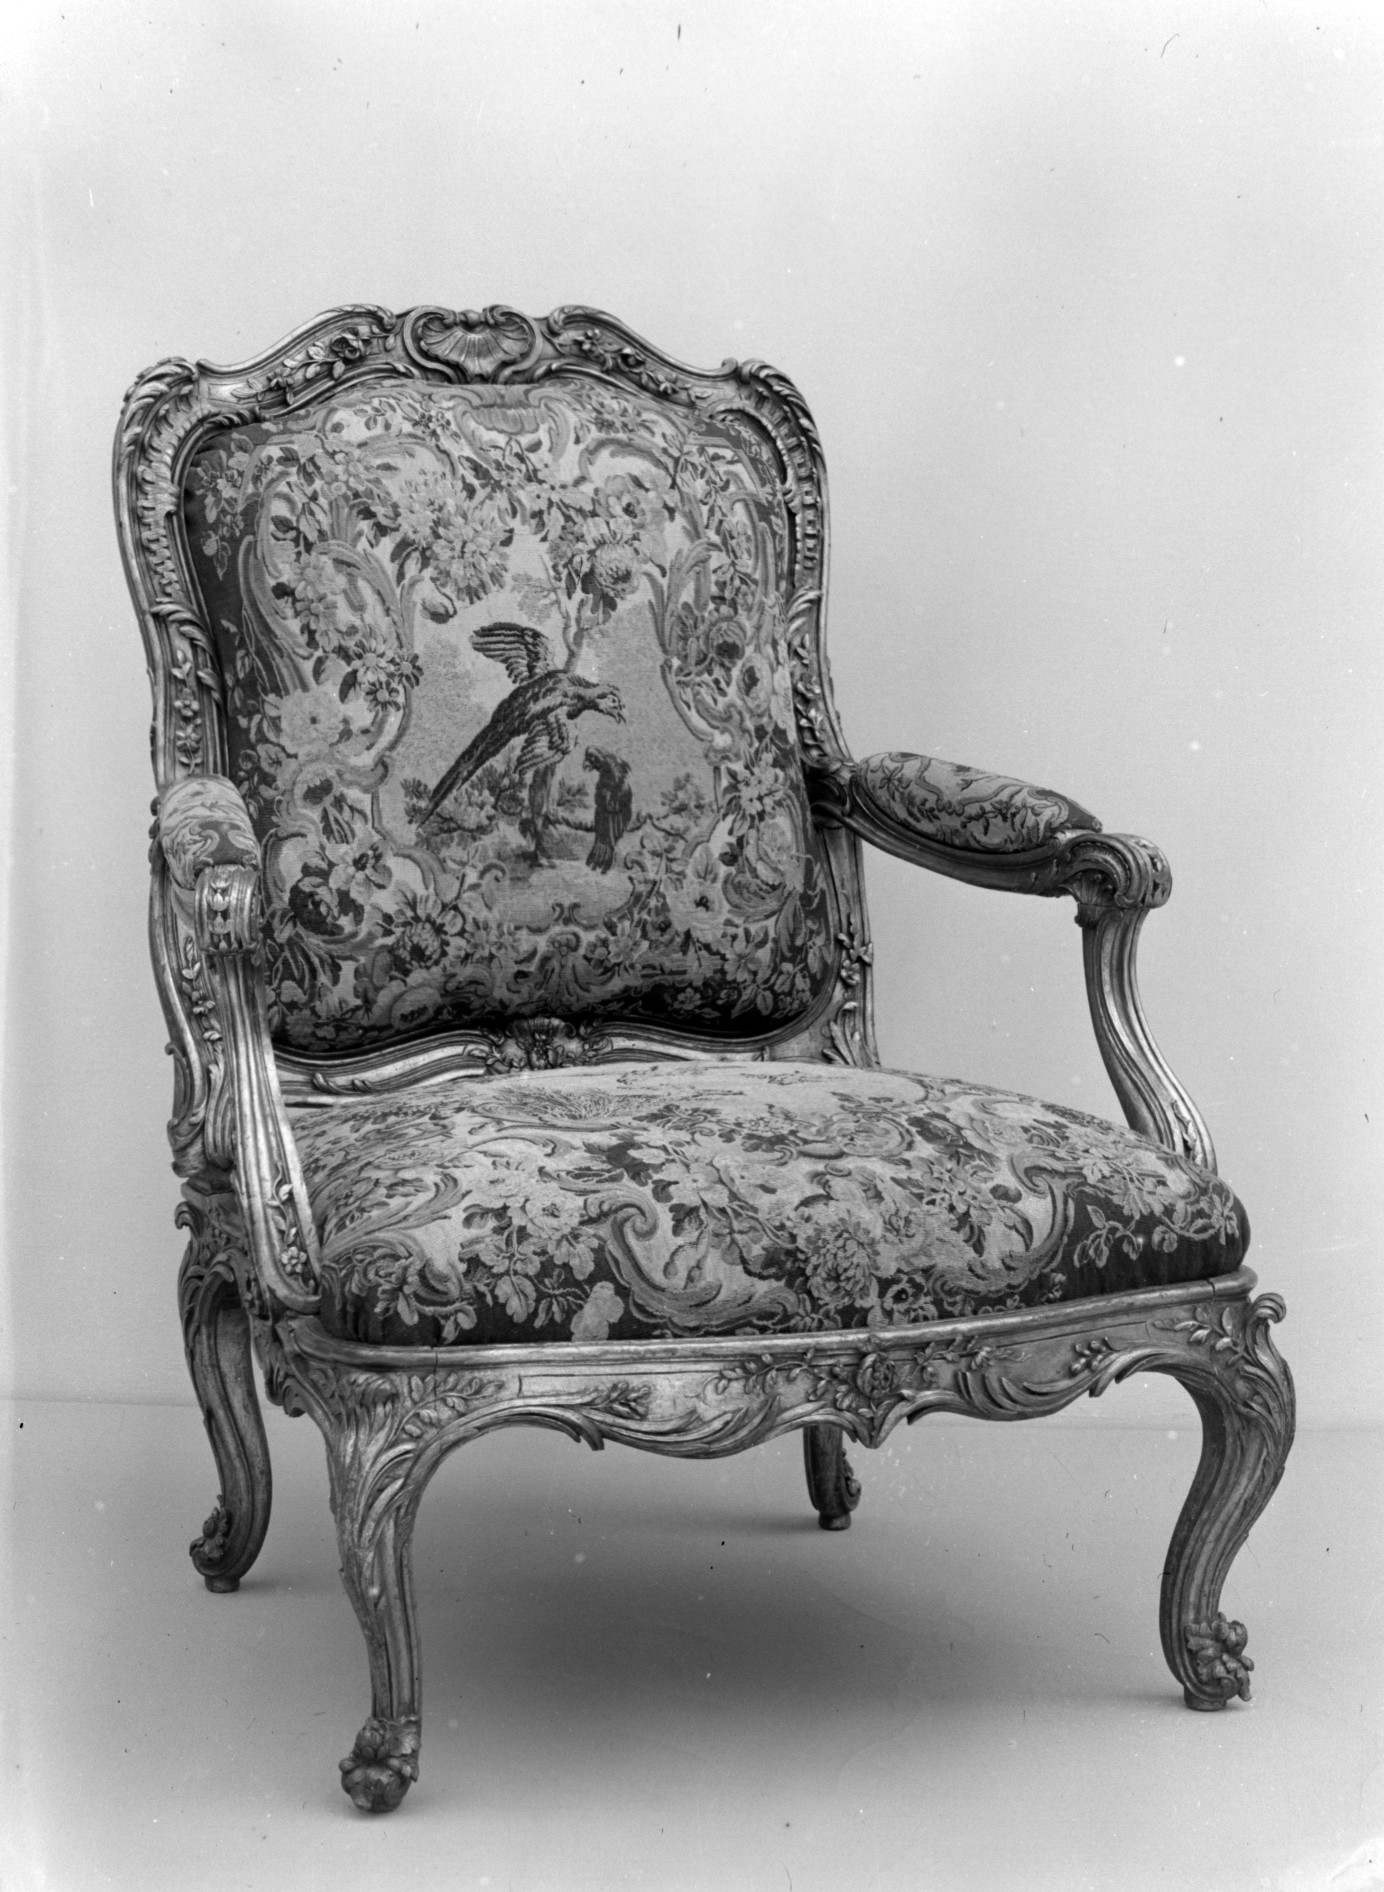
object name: armchair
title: Armchair (part of a set)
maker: nicolas-quinibert foliot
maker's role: maker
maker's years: 1706-1776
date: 1754-1756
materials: wood, silk, wool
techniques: carving, gilding, tapestry